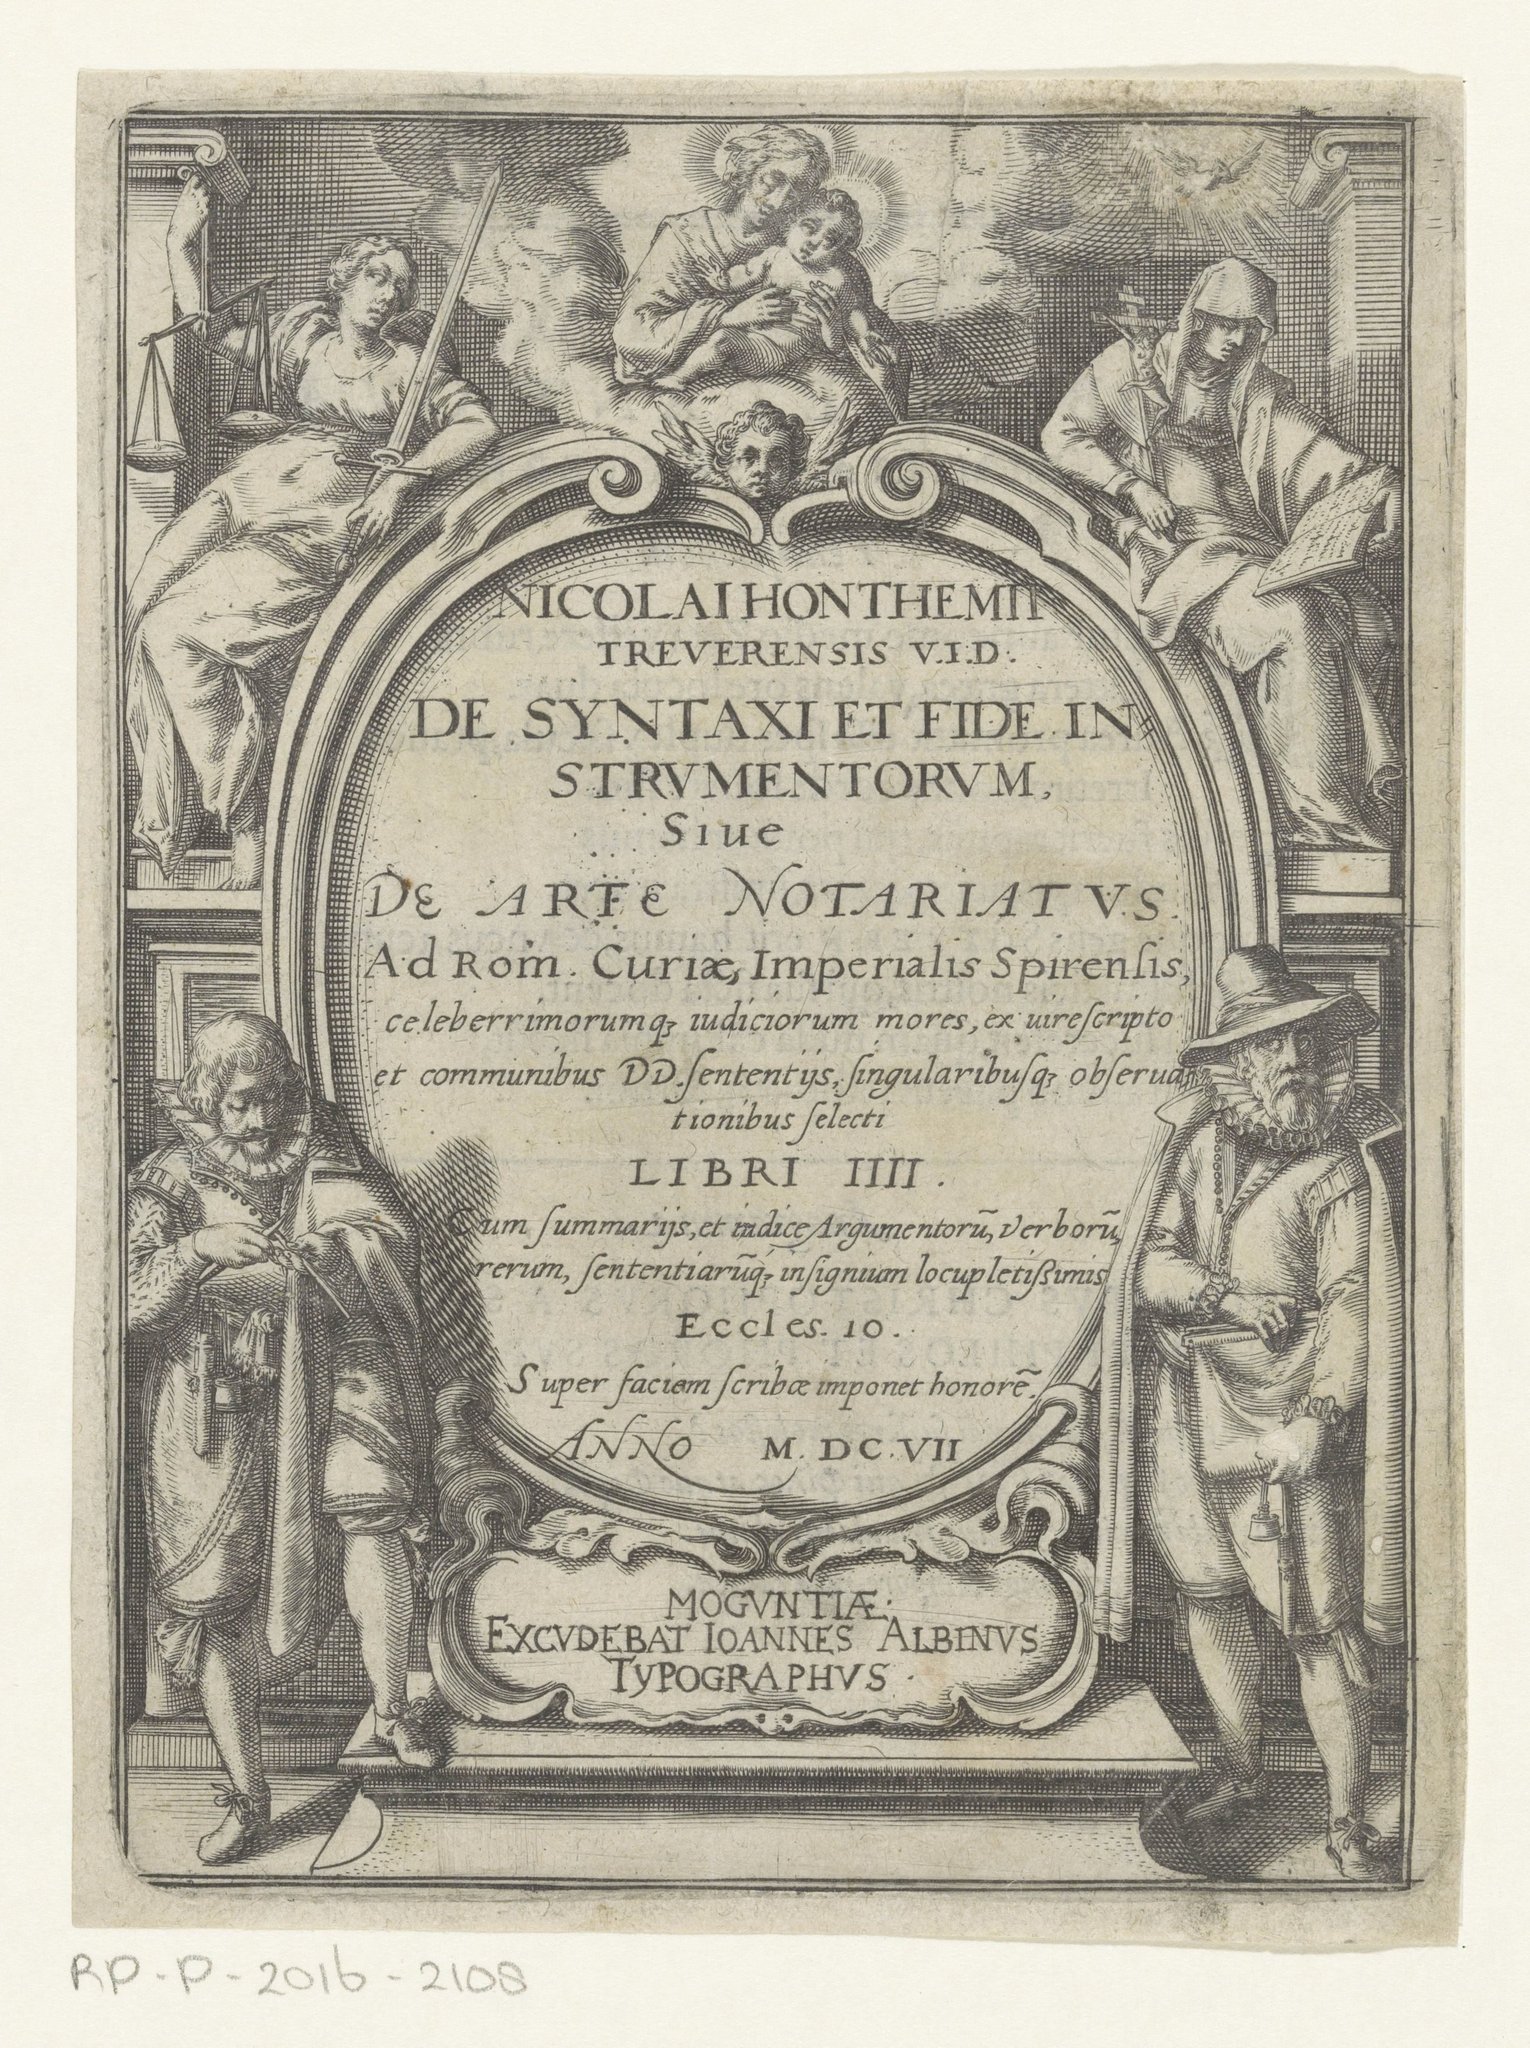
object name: print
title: Titelpagina voor: Nicolaus Hontheim, De syntaxi et fide instrumentorum (...), 1607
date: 1607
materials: paper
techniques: engraving, etching, letterpress printing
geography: mainz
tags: madonna: i.e. mary with the christ-child, faith, 'fides'; 'fede', 'fede catholica', 'fede christiana', 'fede christiana catholica' (ripa) ~ one of the three theological virtues, justice; 'forza alla giustitia sottoposta', 'giustitia', 'giustitia retta', 'giustitia rigorosa', 'impietà e violenza soggetta alla giustitia' (ripa)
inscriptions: collector's mark: Lugt 2228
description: Boven de titel in cartouche zitten Maria en Christus geflankeerd door Rechtvaardigheid met zwaard en weegschaal en Geloof met kruis en bijbel. Aan de voorzijde staan twee mannen.